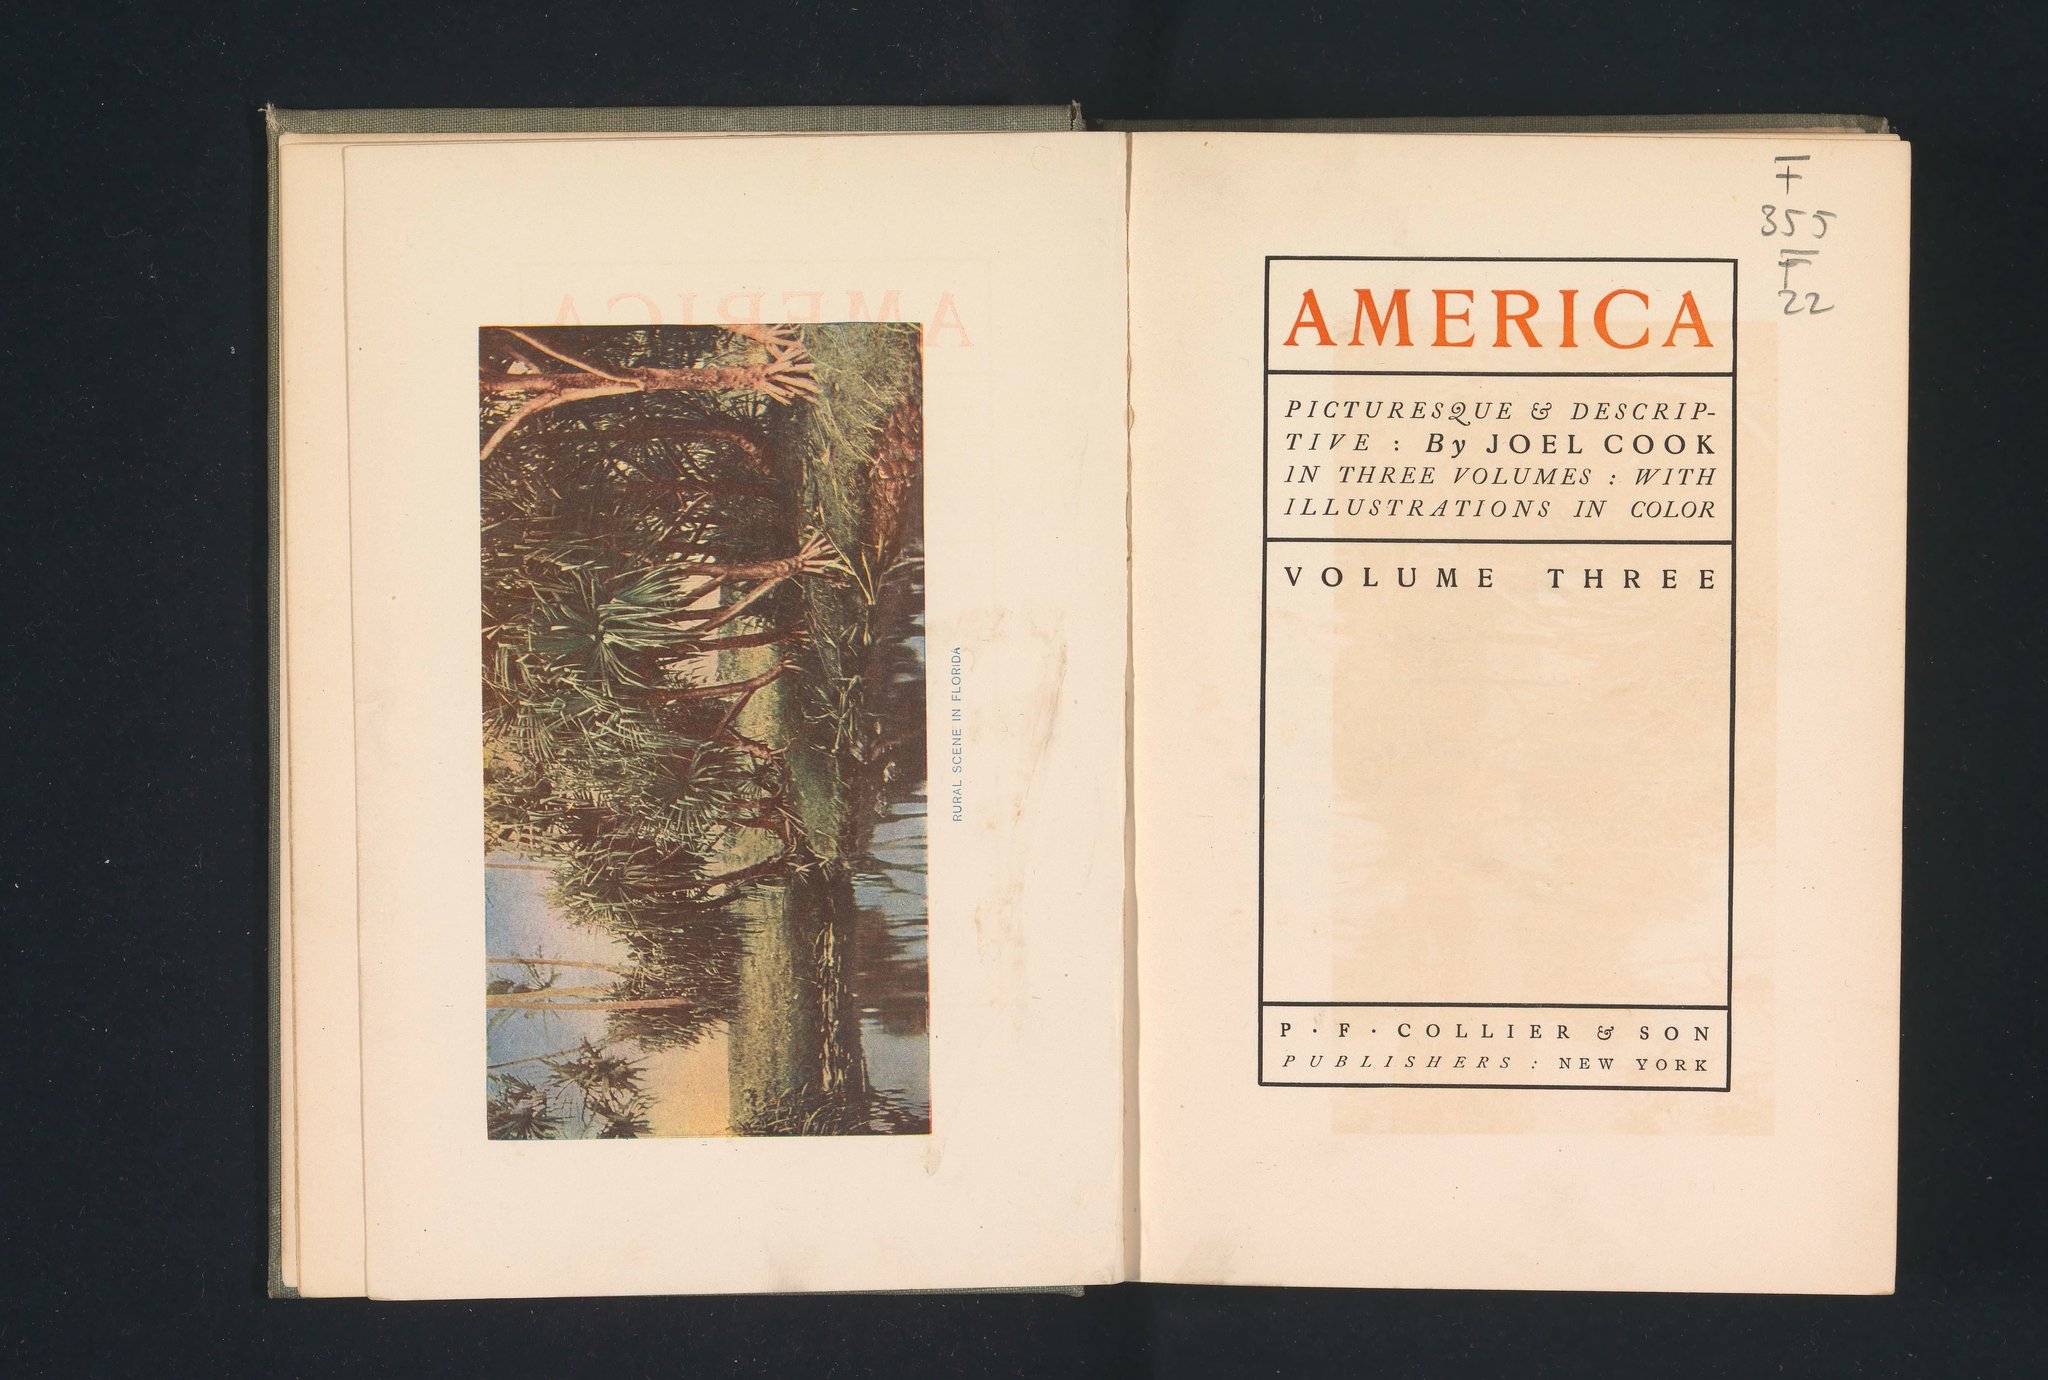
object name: book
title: America : picturesque and descriptive volume three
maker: joel cook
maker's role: politician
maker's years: 1842-1910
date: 1900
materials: cardboard, linen, paper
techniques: printing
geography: new york city